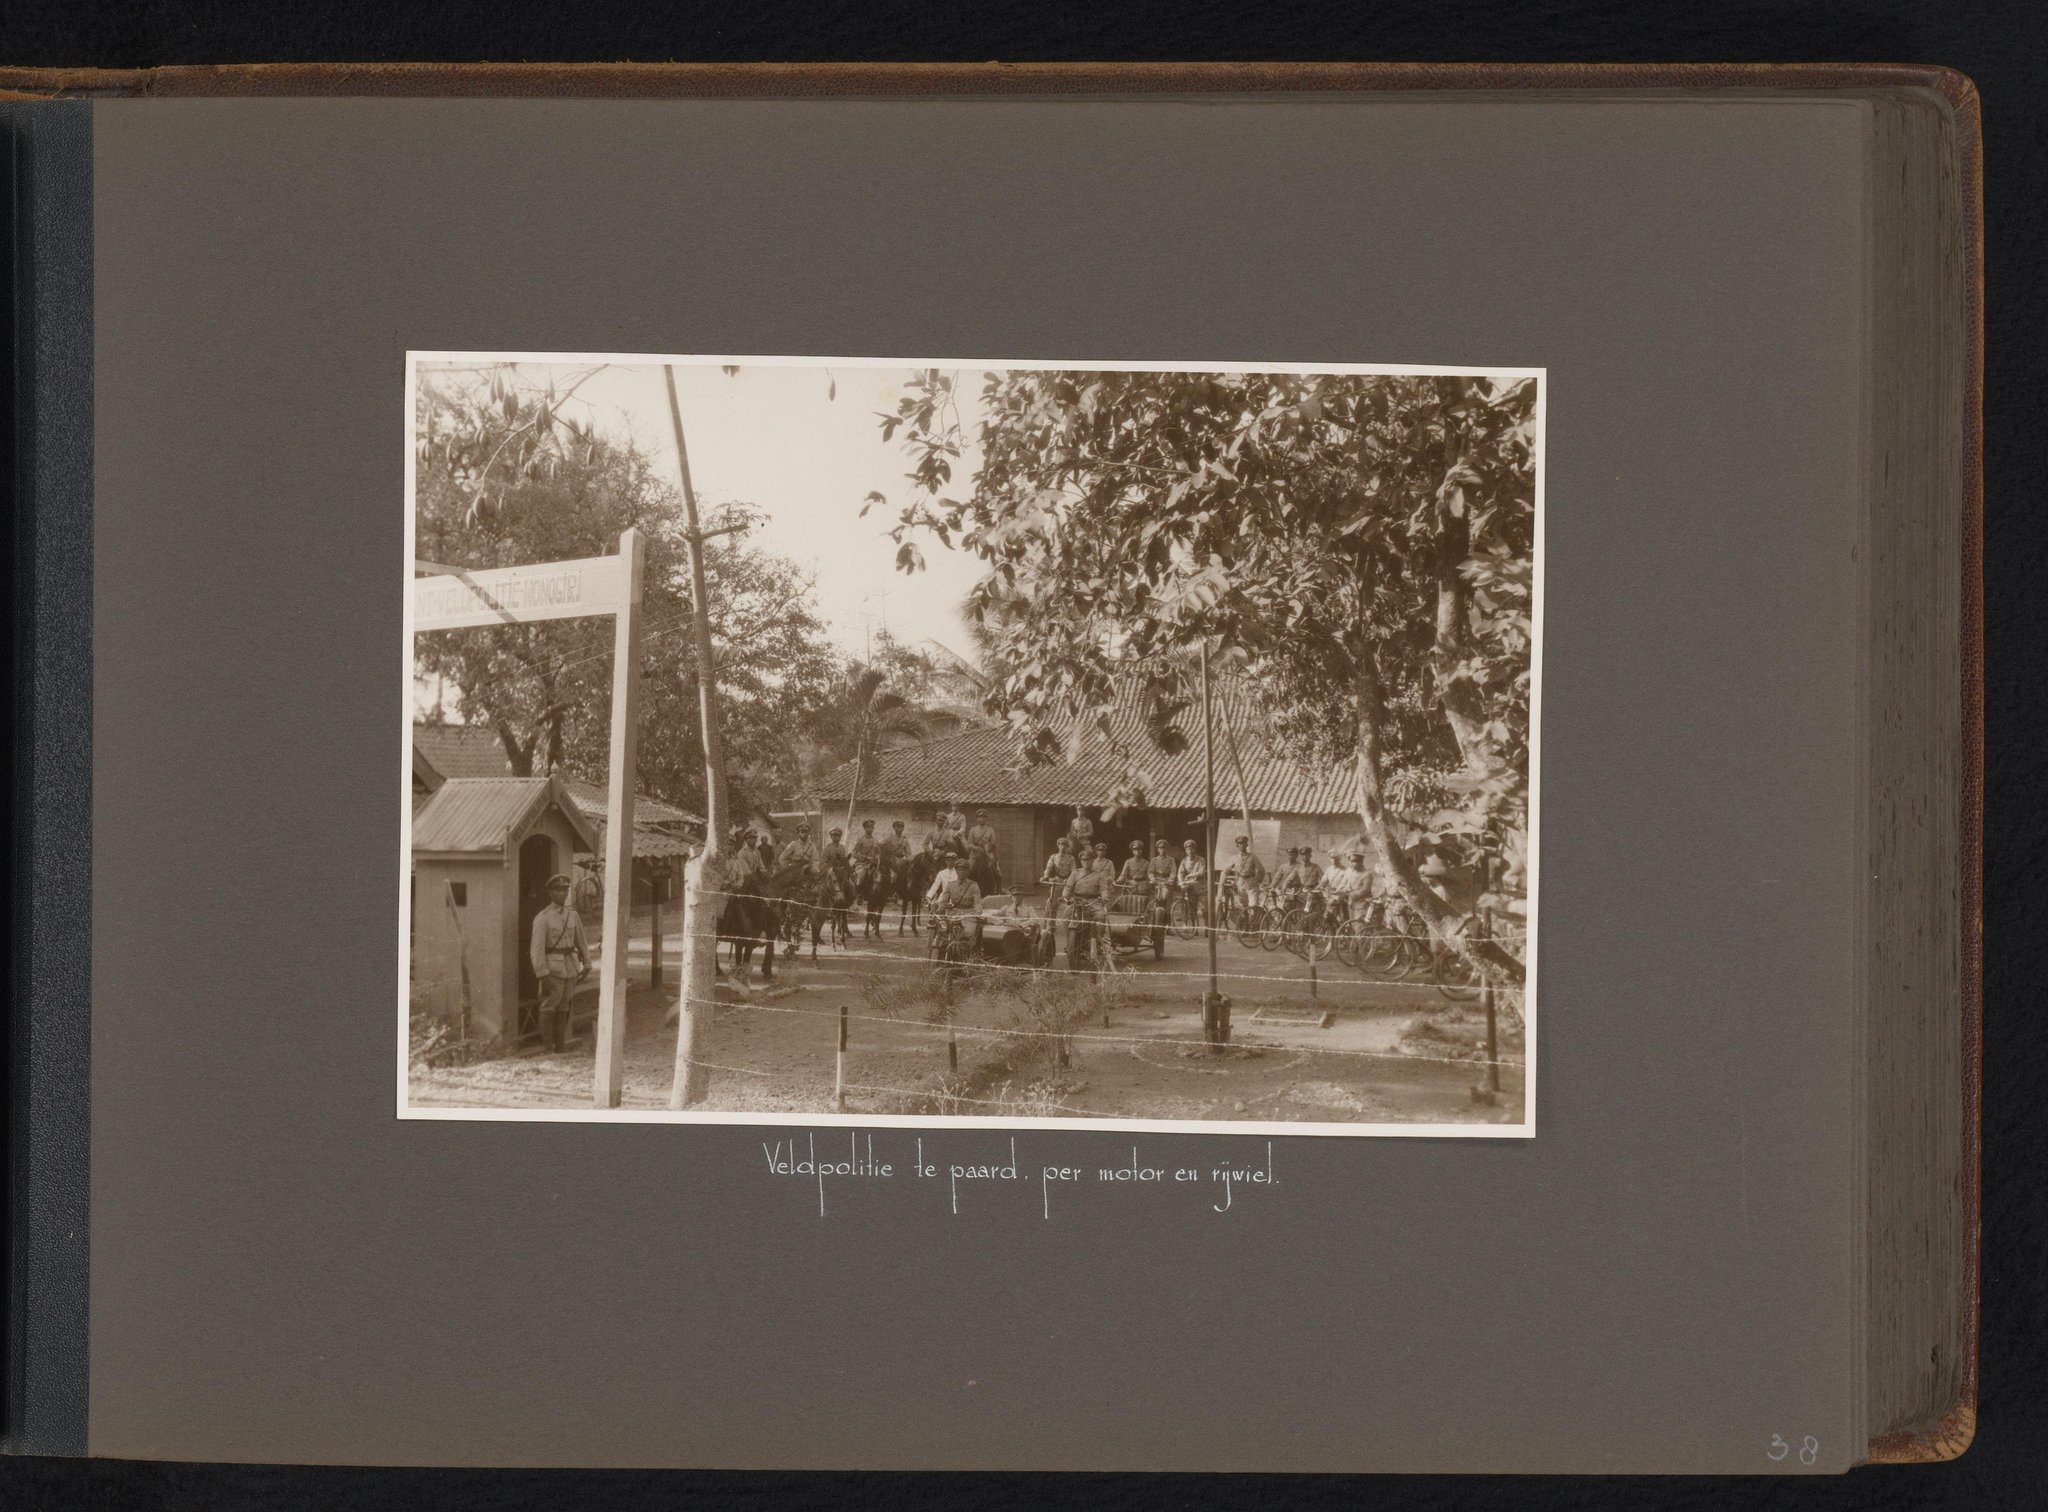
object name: photograph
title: Veldpolitie te paard, pet motor en rijwiel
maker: Anonymous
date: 1925-1931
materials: cardboard, photographic support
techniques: gelatin silver print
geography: solo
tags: dutch east indies, the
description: Albumblad met één foto: politie te paard, motor en op de fiets, voor het gebouw van de veldpolitie van Wonogiri te Solo. Onderdeel van het fotoalbum aangeboden aan S. Koster door de Vereeniging van Hoogere Politie Ambtenaren in Nederlandsch-Indië in 1931.